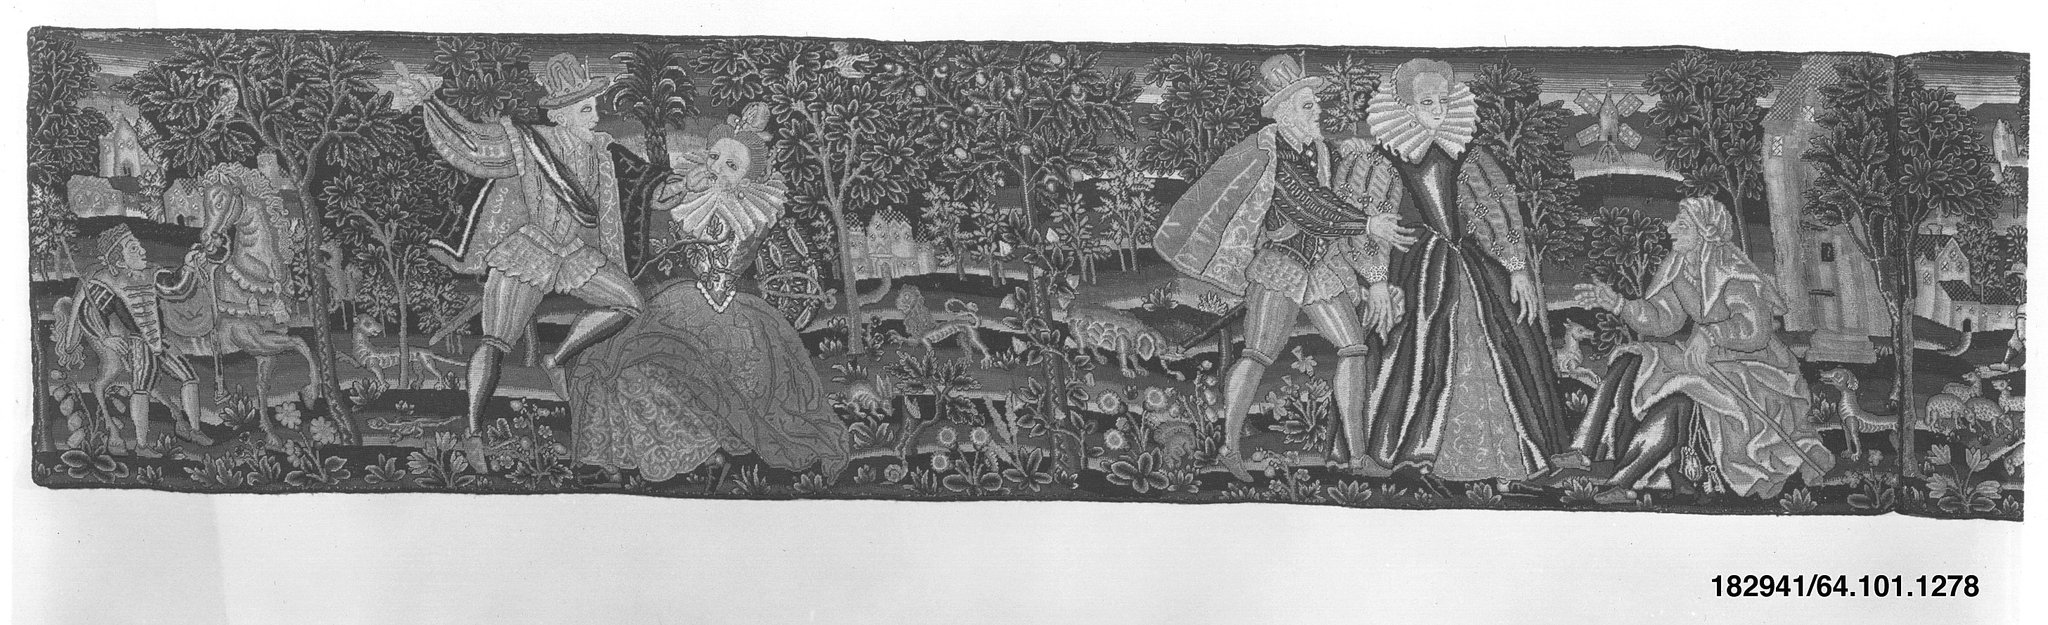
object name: valance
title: The Story of Philomela (one of two)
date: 1600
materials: canvas, silk, wool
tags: men,women,dogs,horses,lions